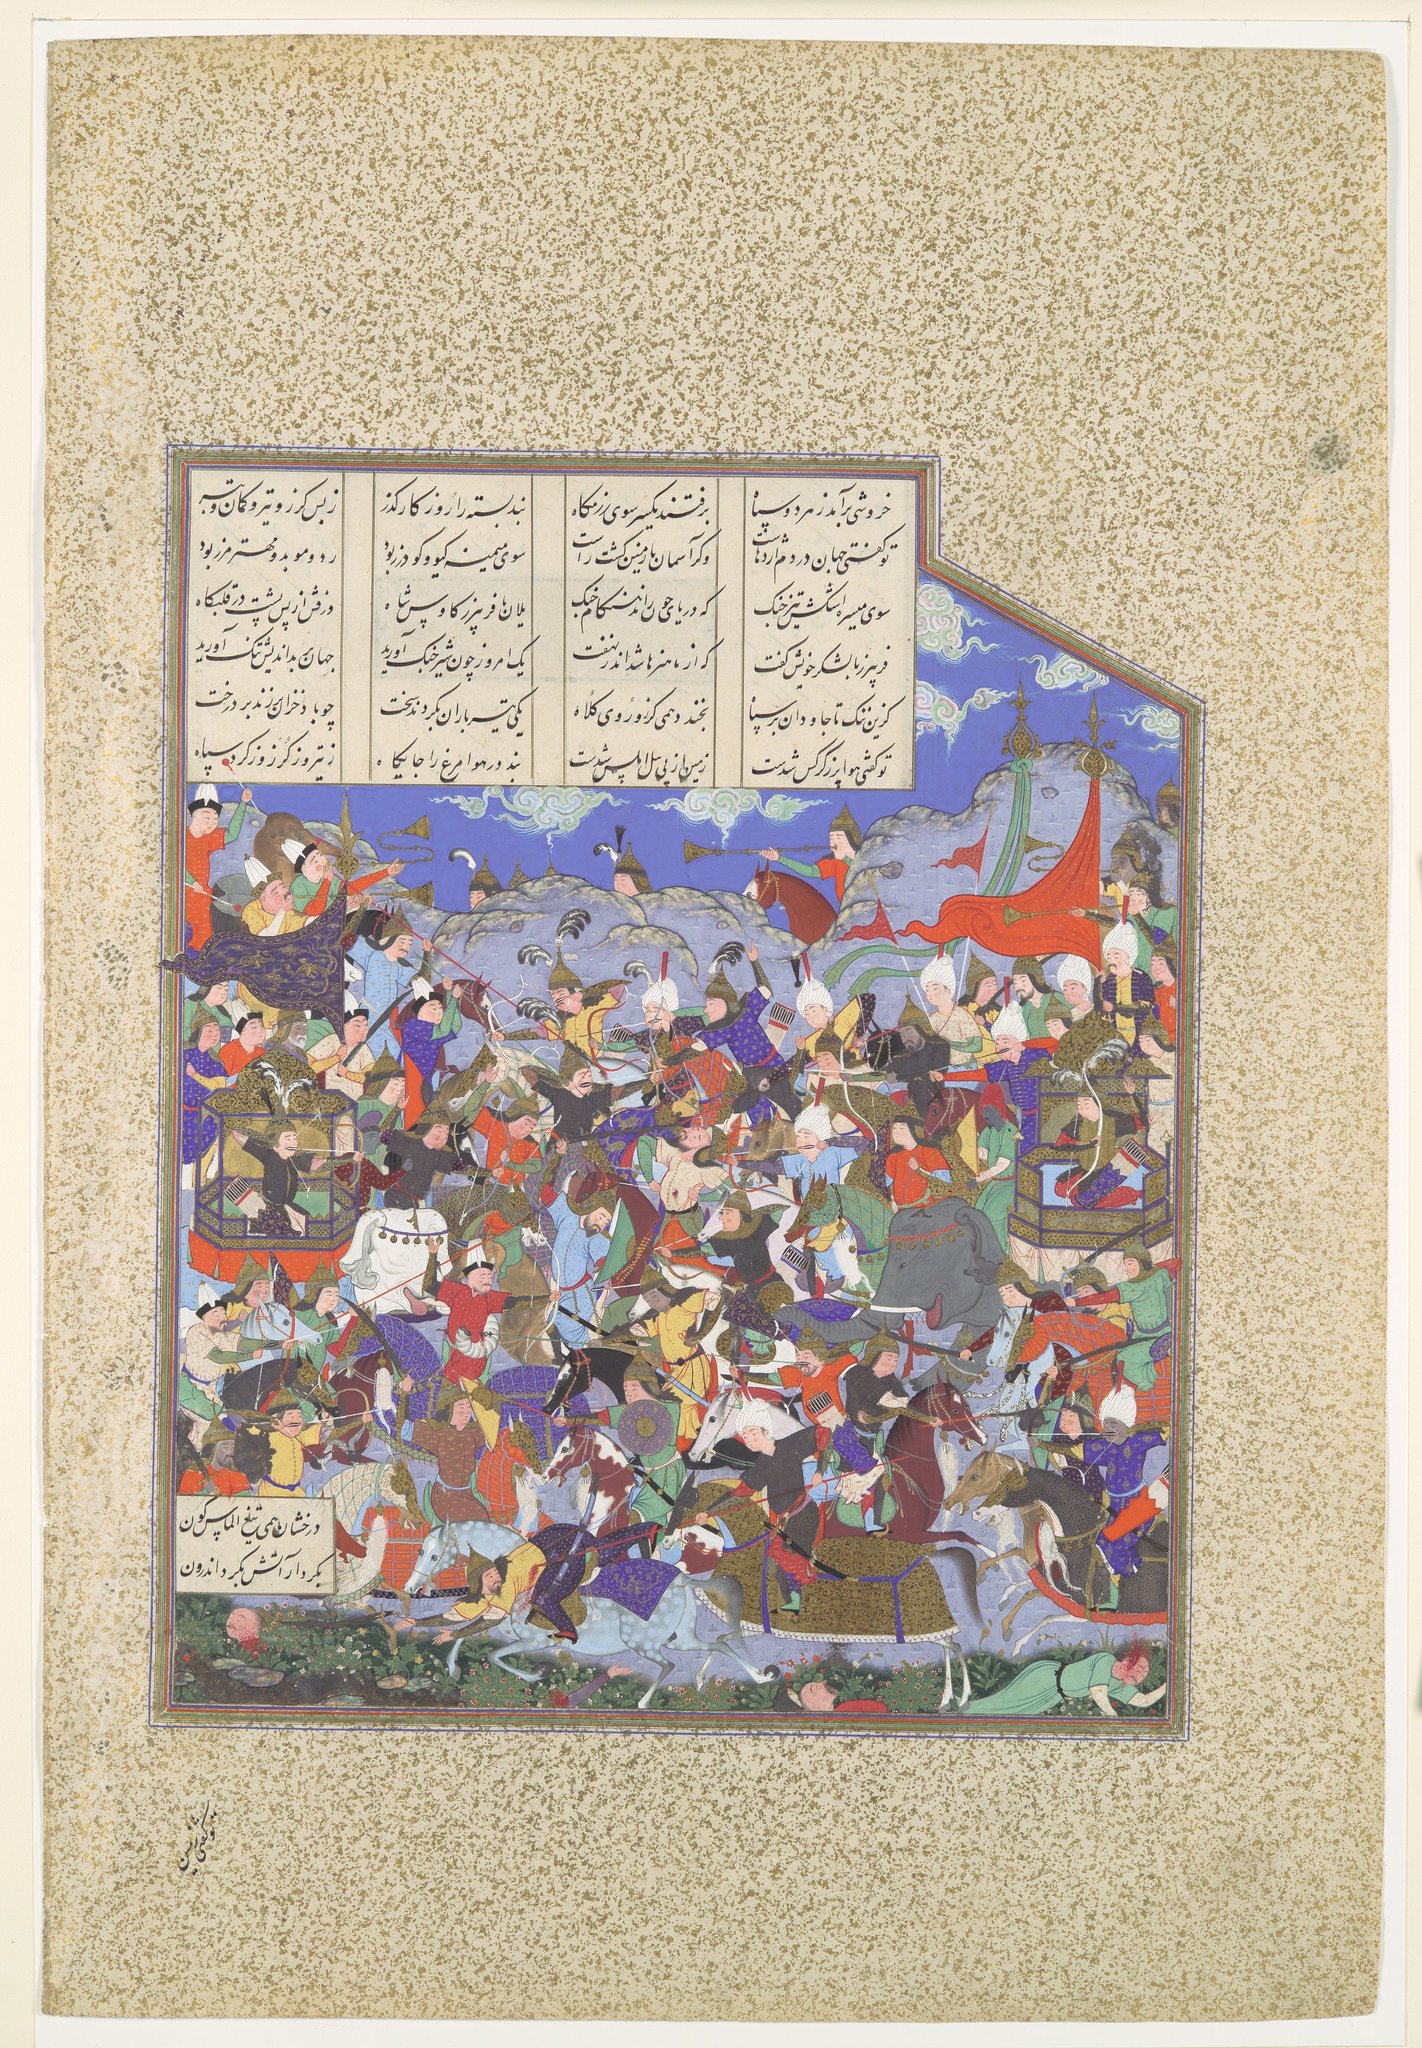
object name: folio from an illustrated manuscript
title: "The Battle of Pashan Begins", Folio 243v from the Shahnama (Book of Kings) of Shah Tahmasp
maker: abu'l qasim firdausi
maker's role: author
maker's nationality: iranian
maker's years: 935-1020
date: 1530-1535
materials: gold, ink, paper, silver, watercolor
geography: iran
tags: battles,men,horses